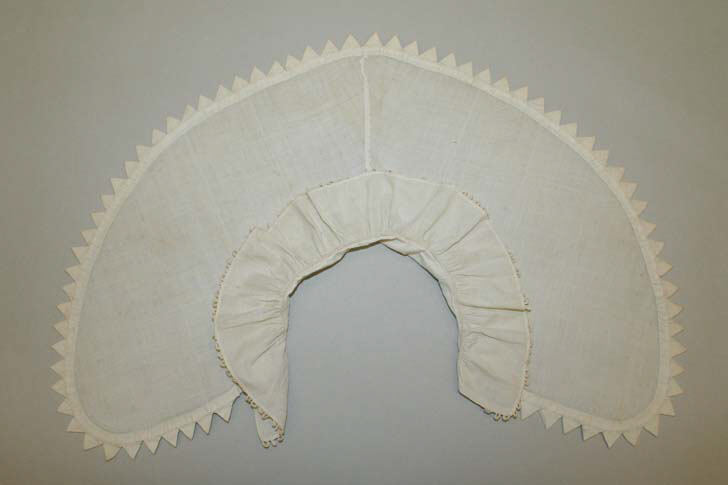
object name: collar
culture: american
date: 1820